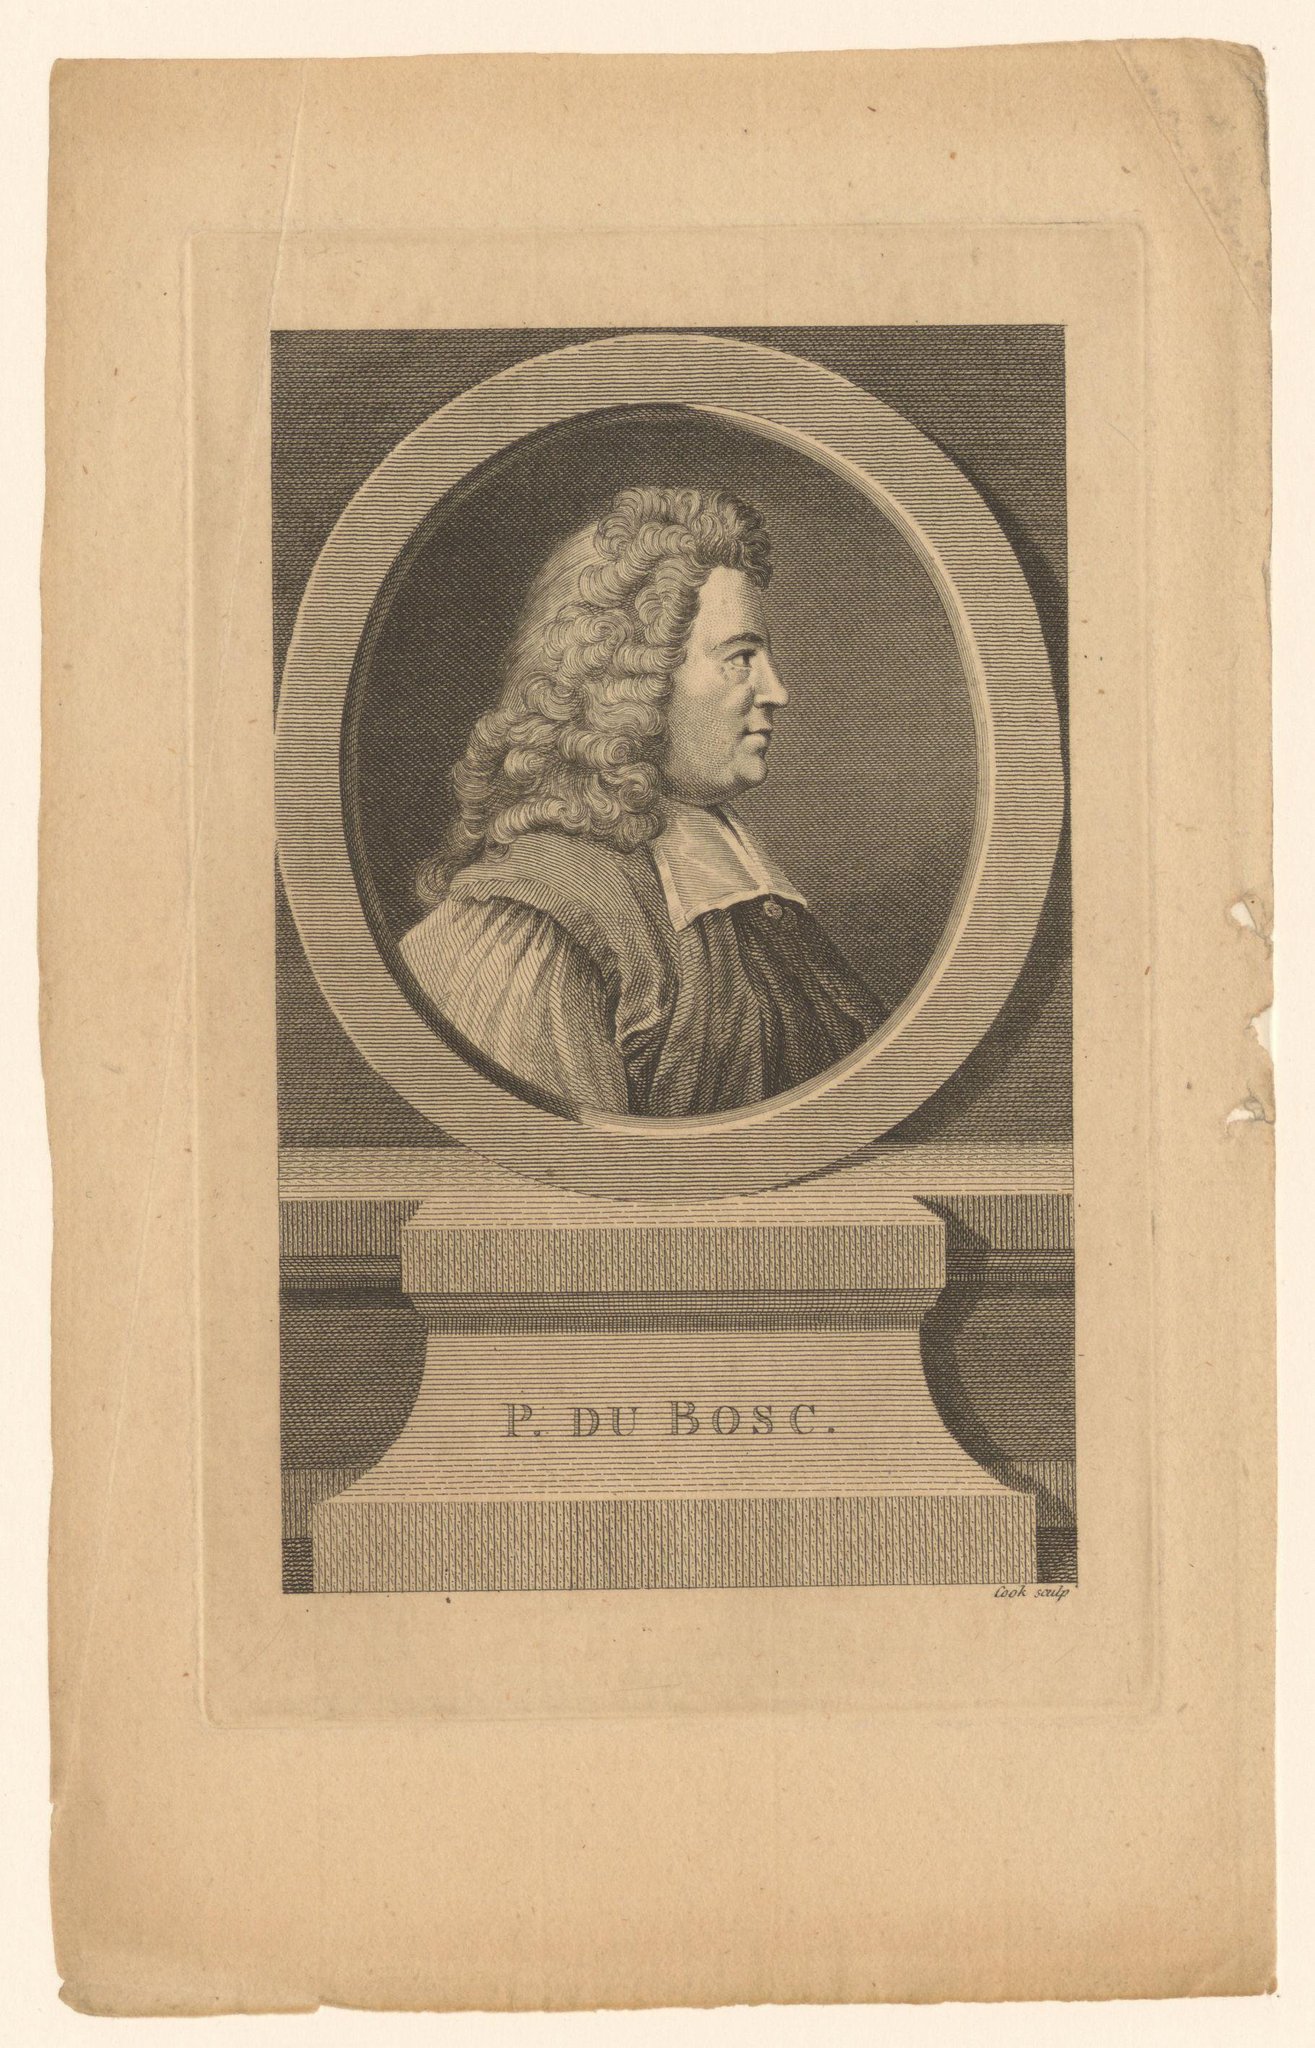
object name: print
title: Portret van Pierre du Bosc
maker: thomas cook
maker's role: print maker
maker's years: 1744-1818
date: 1754-1818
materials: paper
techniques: engraving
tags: rotterdam, priest, pierre du bosc, theologian, historical persons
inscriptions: collector's mark: Lugt 2228